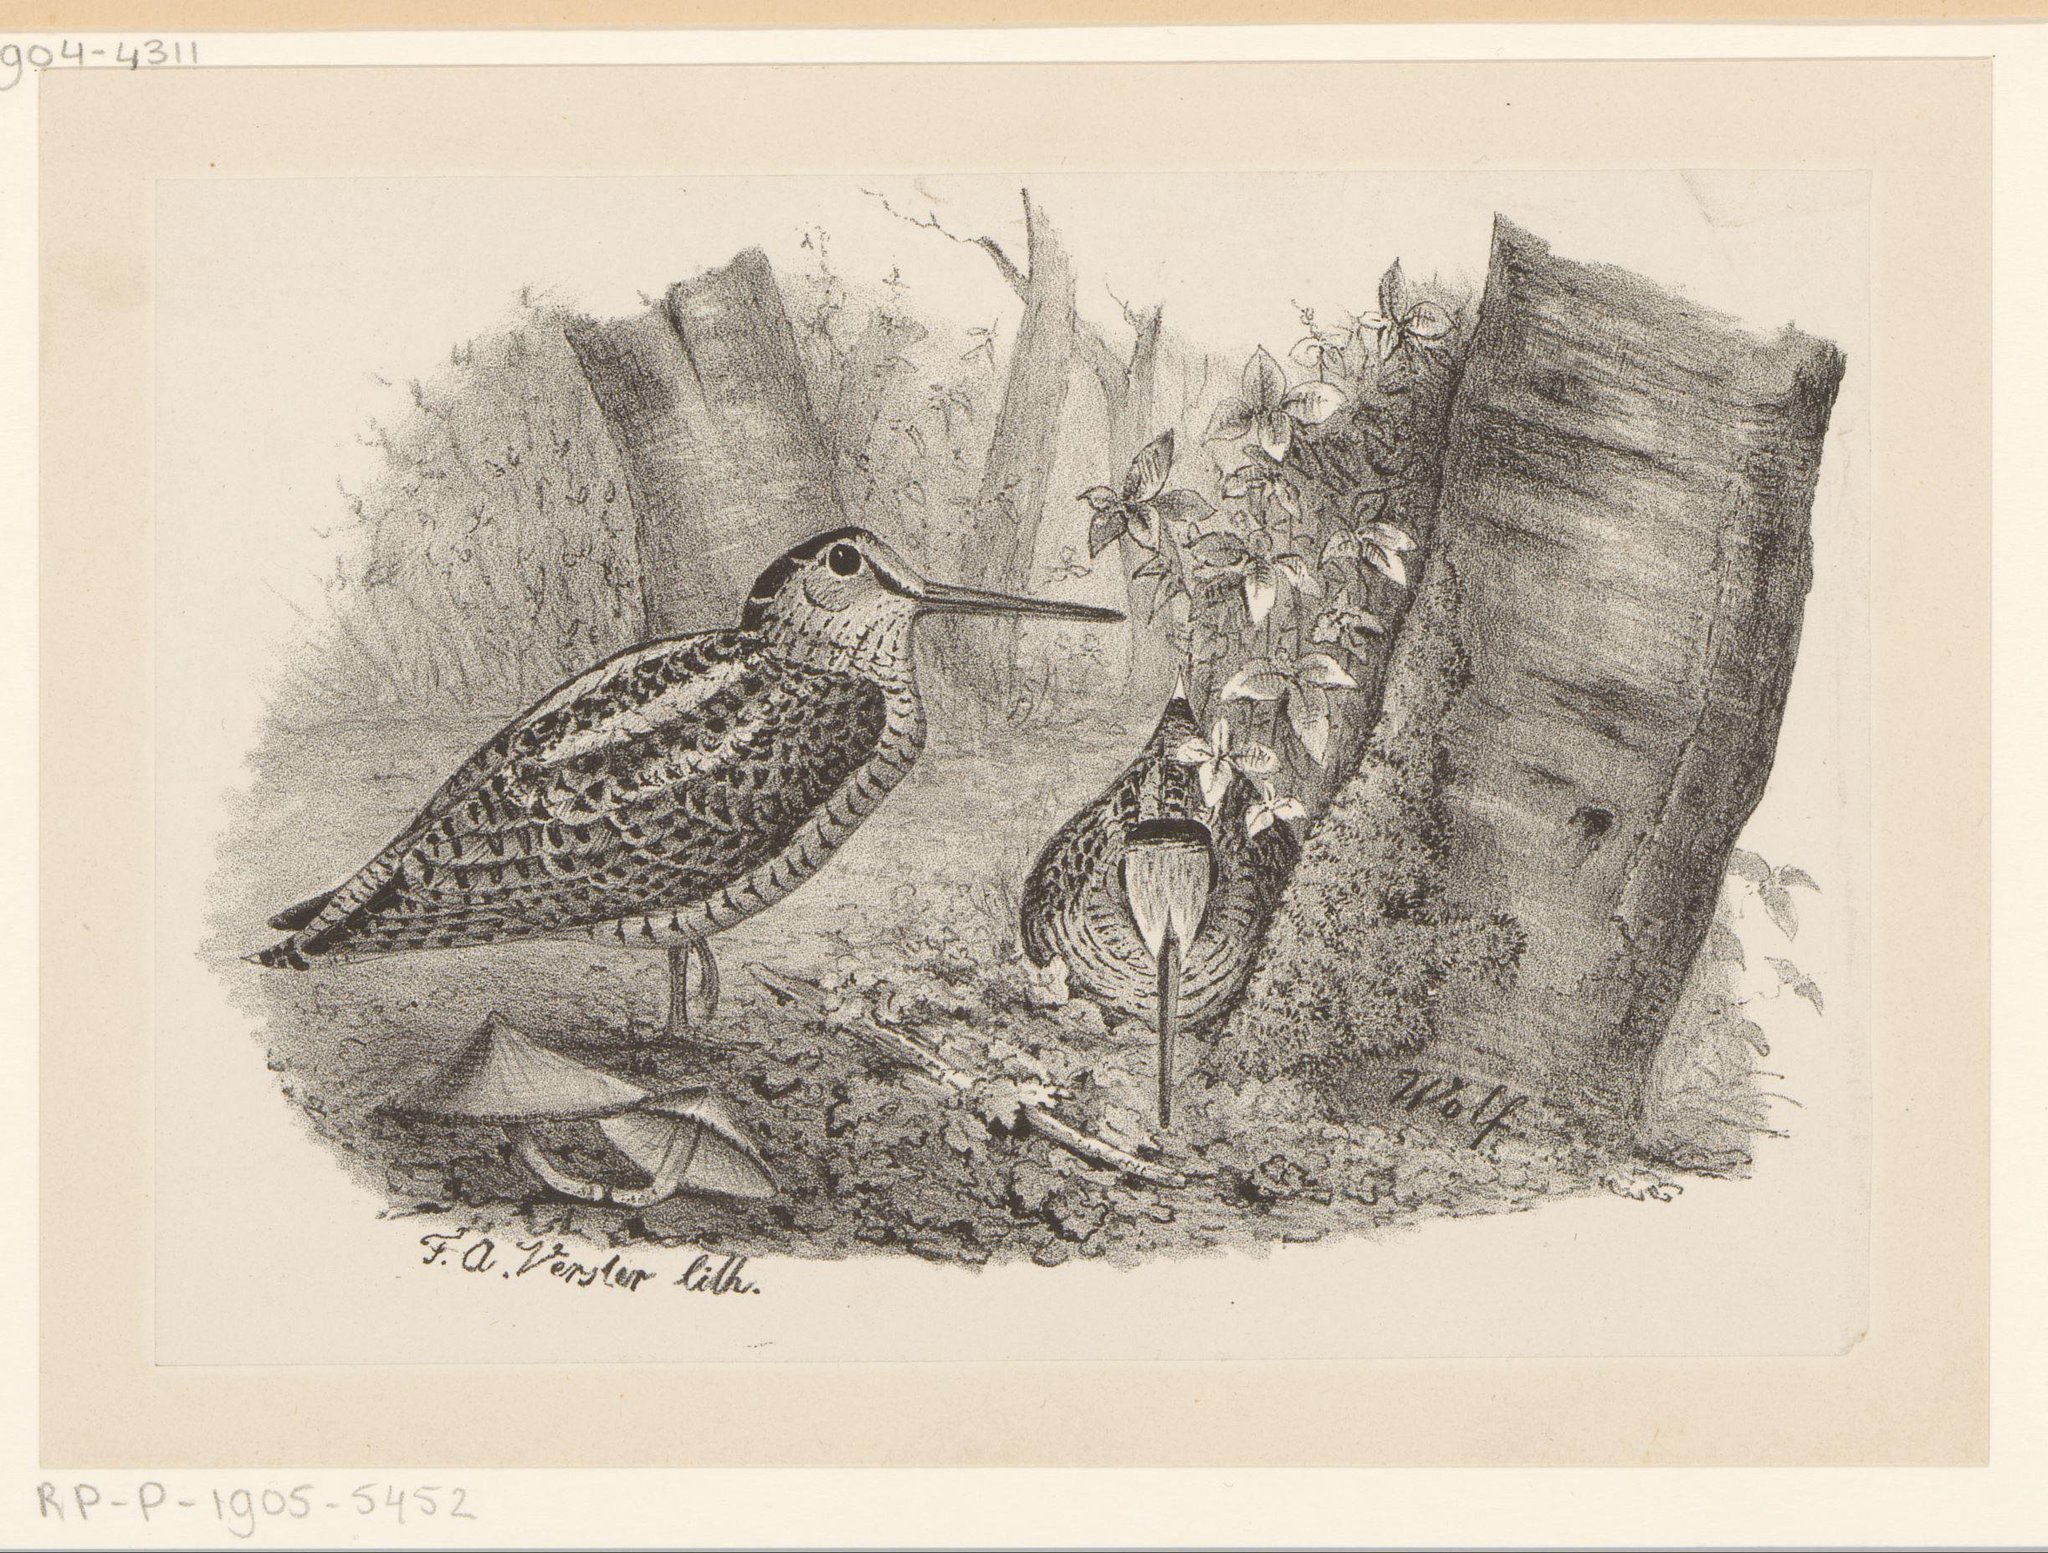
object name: print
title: Twee houtsnippen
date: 1836-1905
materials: paper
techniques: lithograph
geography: netherlands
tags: shore-birds and wading-birds: woodcock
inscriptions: collector's mark: Lugt 2228